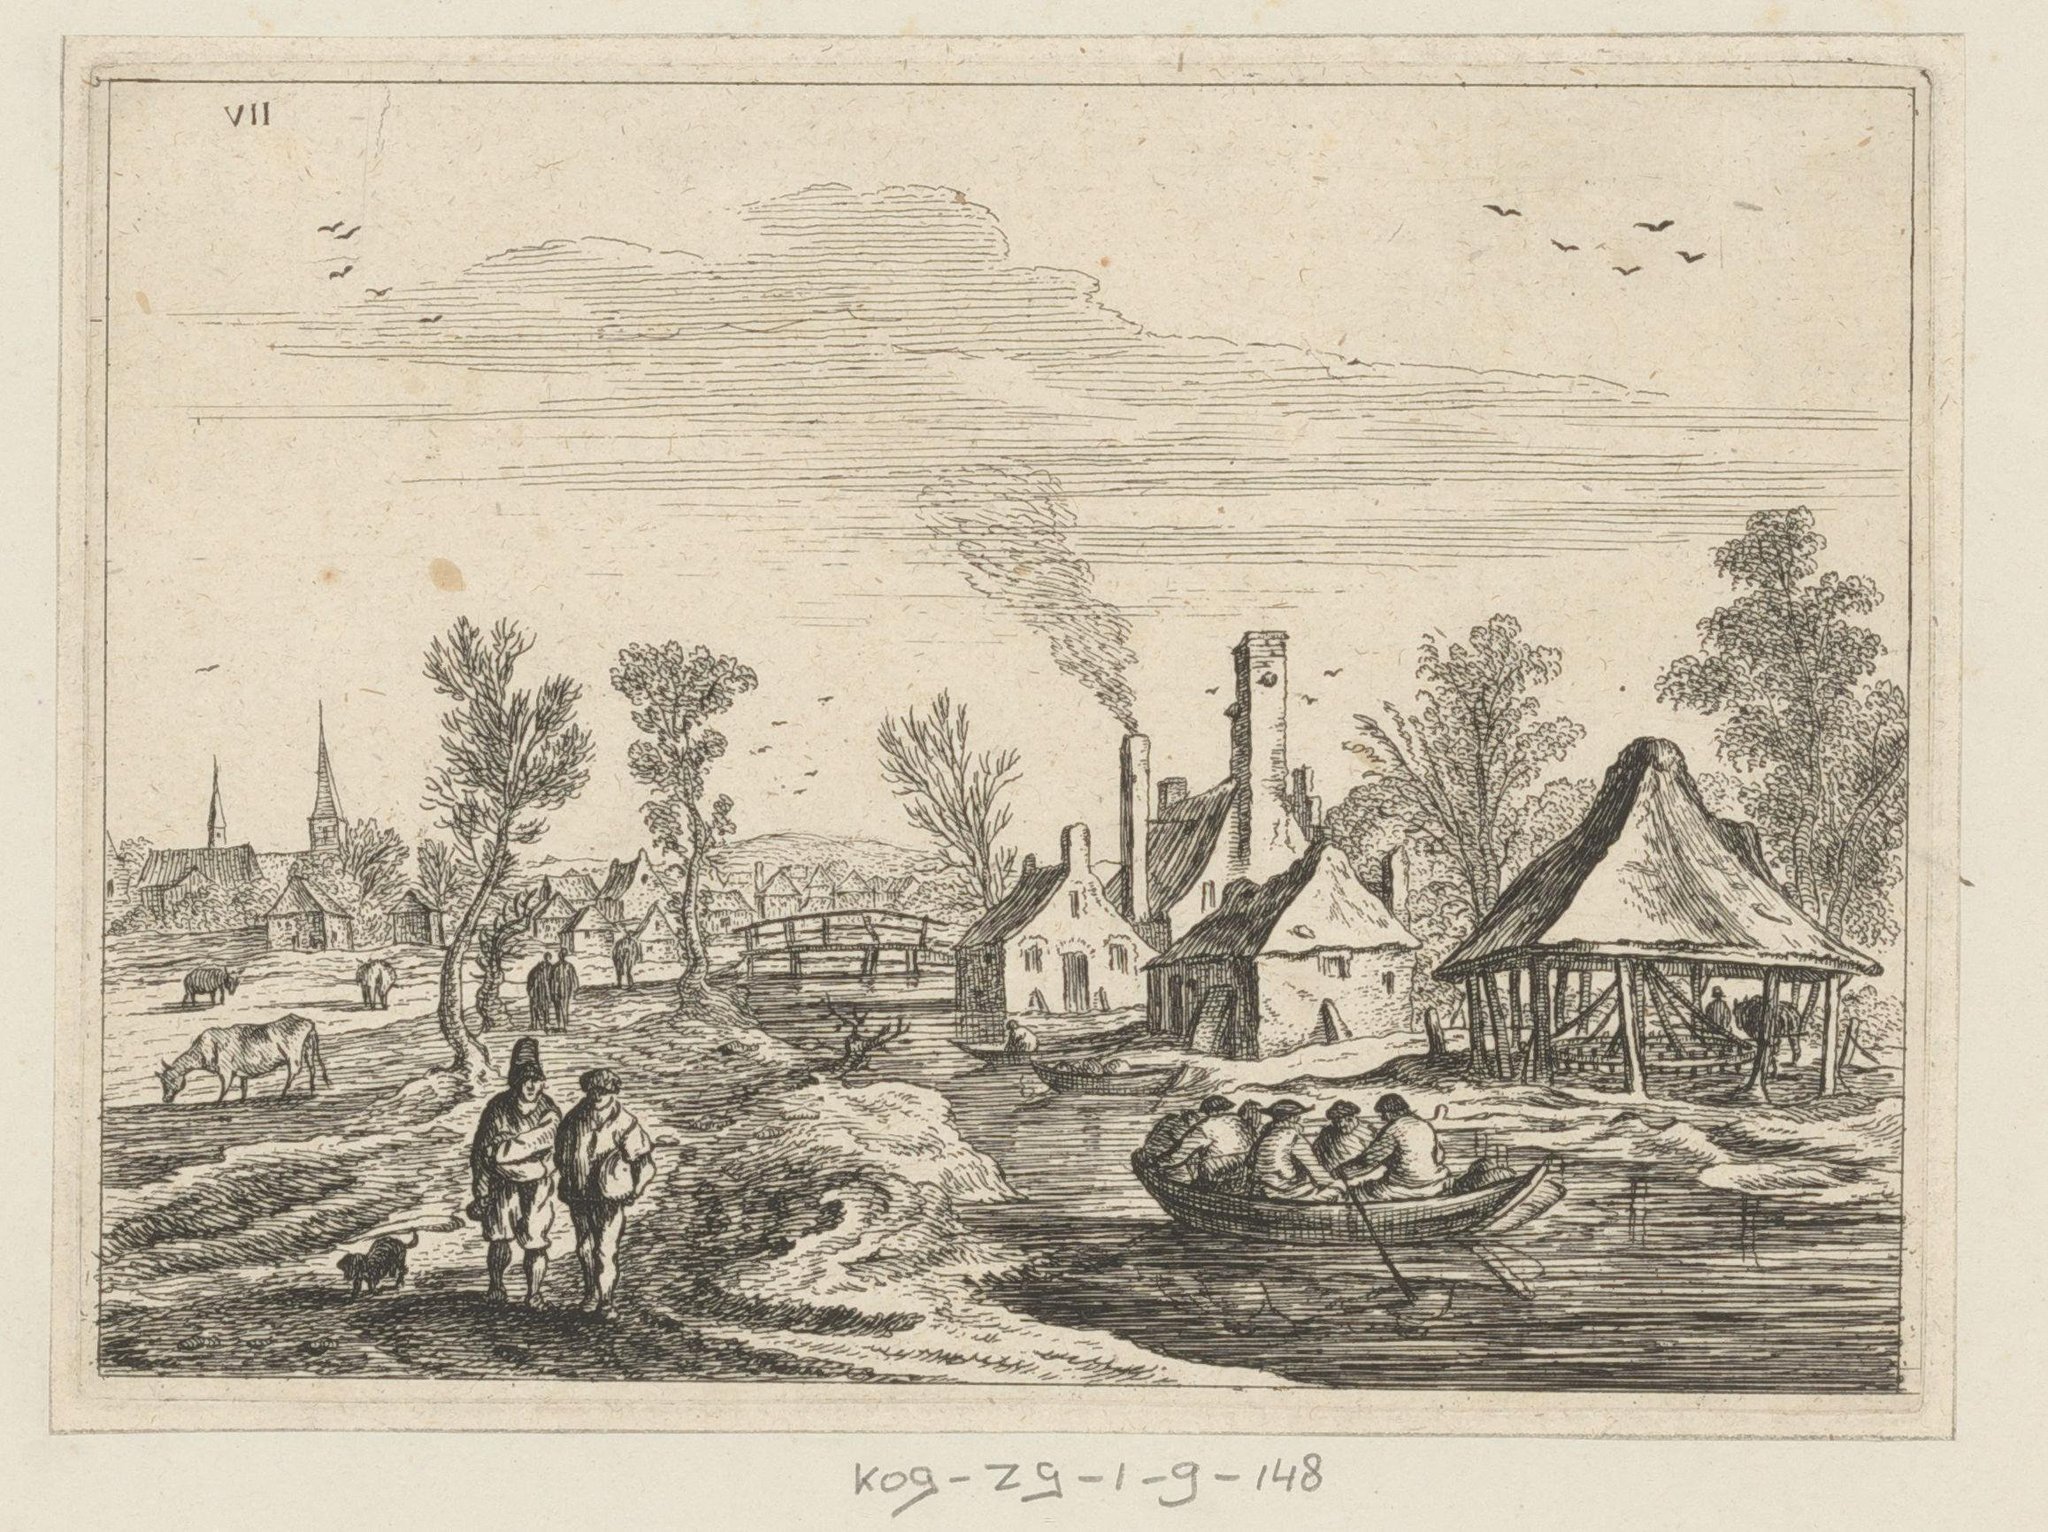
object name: print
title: Landschappen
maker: johannes gronsveld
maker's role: draughtsman, painter, print maker, publisher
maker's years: 1658-1728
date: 1679-1728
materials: paper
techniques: etching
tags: village, rowing-boat, canoe, etc.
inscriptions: collector's mark: Lugt 1641, stamp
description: Landschap met dorp aan rivier met rechts op de voorgrond mannen in een roeiboot en links twee mannen en een hond wandelend over een pad langs de rivier. Zevende prent uit een serie van acht met landschappen. Rechtsboven genummerd: VII. Onderwerpsrubrieken binnen de Atlas Zeden en Gewoonten: Handel, nijverheid en verkeer, Buitenleven.